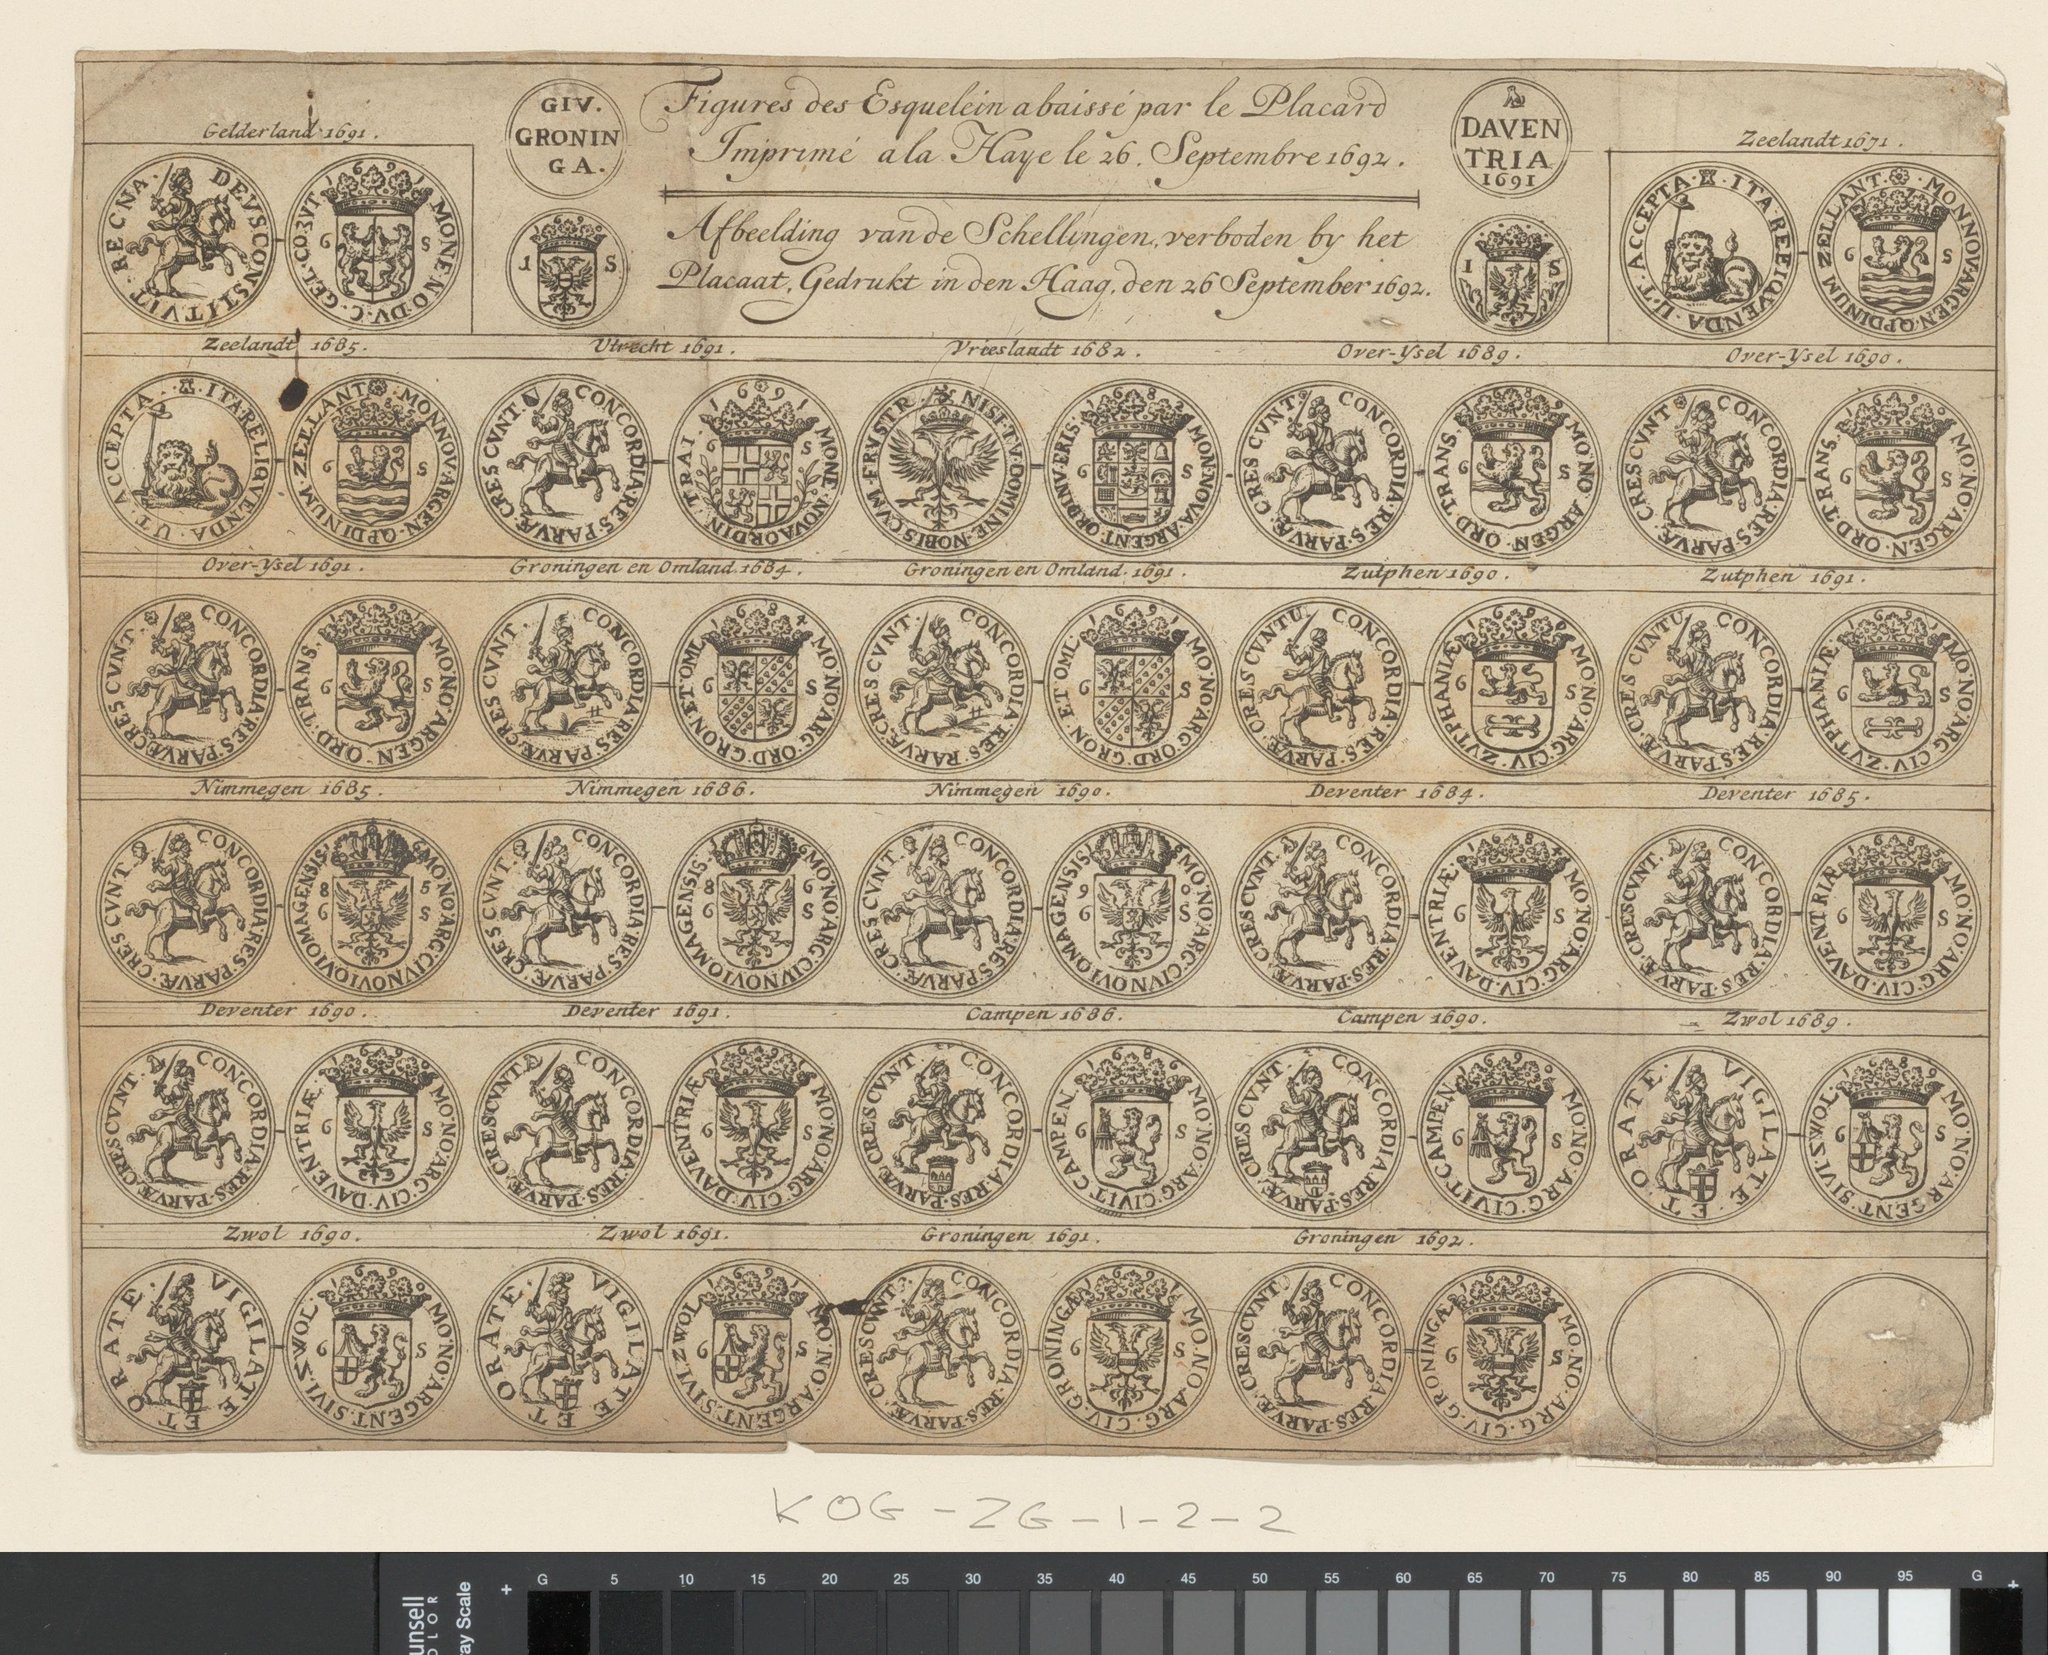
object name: print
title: Figures des Esquelein a baissé par le Placard / Afbeelding van de Schellingen, verboden by het Placaat ... 26 September 1692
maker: Anonymous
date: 1692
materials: paper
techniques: etching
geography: netherlands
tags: coin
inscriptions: collector's mark, collector's mark: Lugt 1641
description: Blad met de voor- en keerzijde van 28 munten van provincies van de Republiek uit de jaren 1671-1692. Uit het Hollandse plakkaat van 26 september 1692. Onderwerpsrubrieken binnen de Atlas Zeden en Gewoonten: Regeering, Muntwezen.